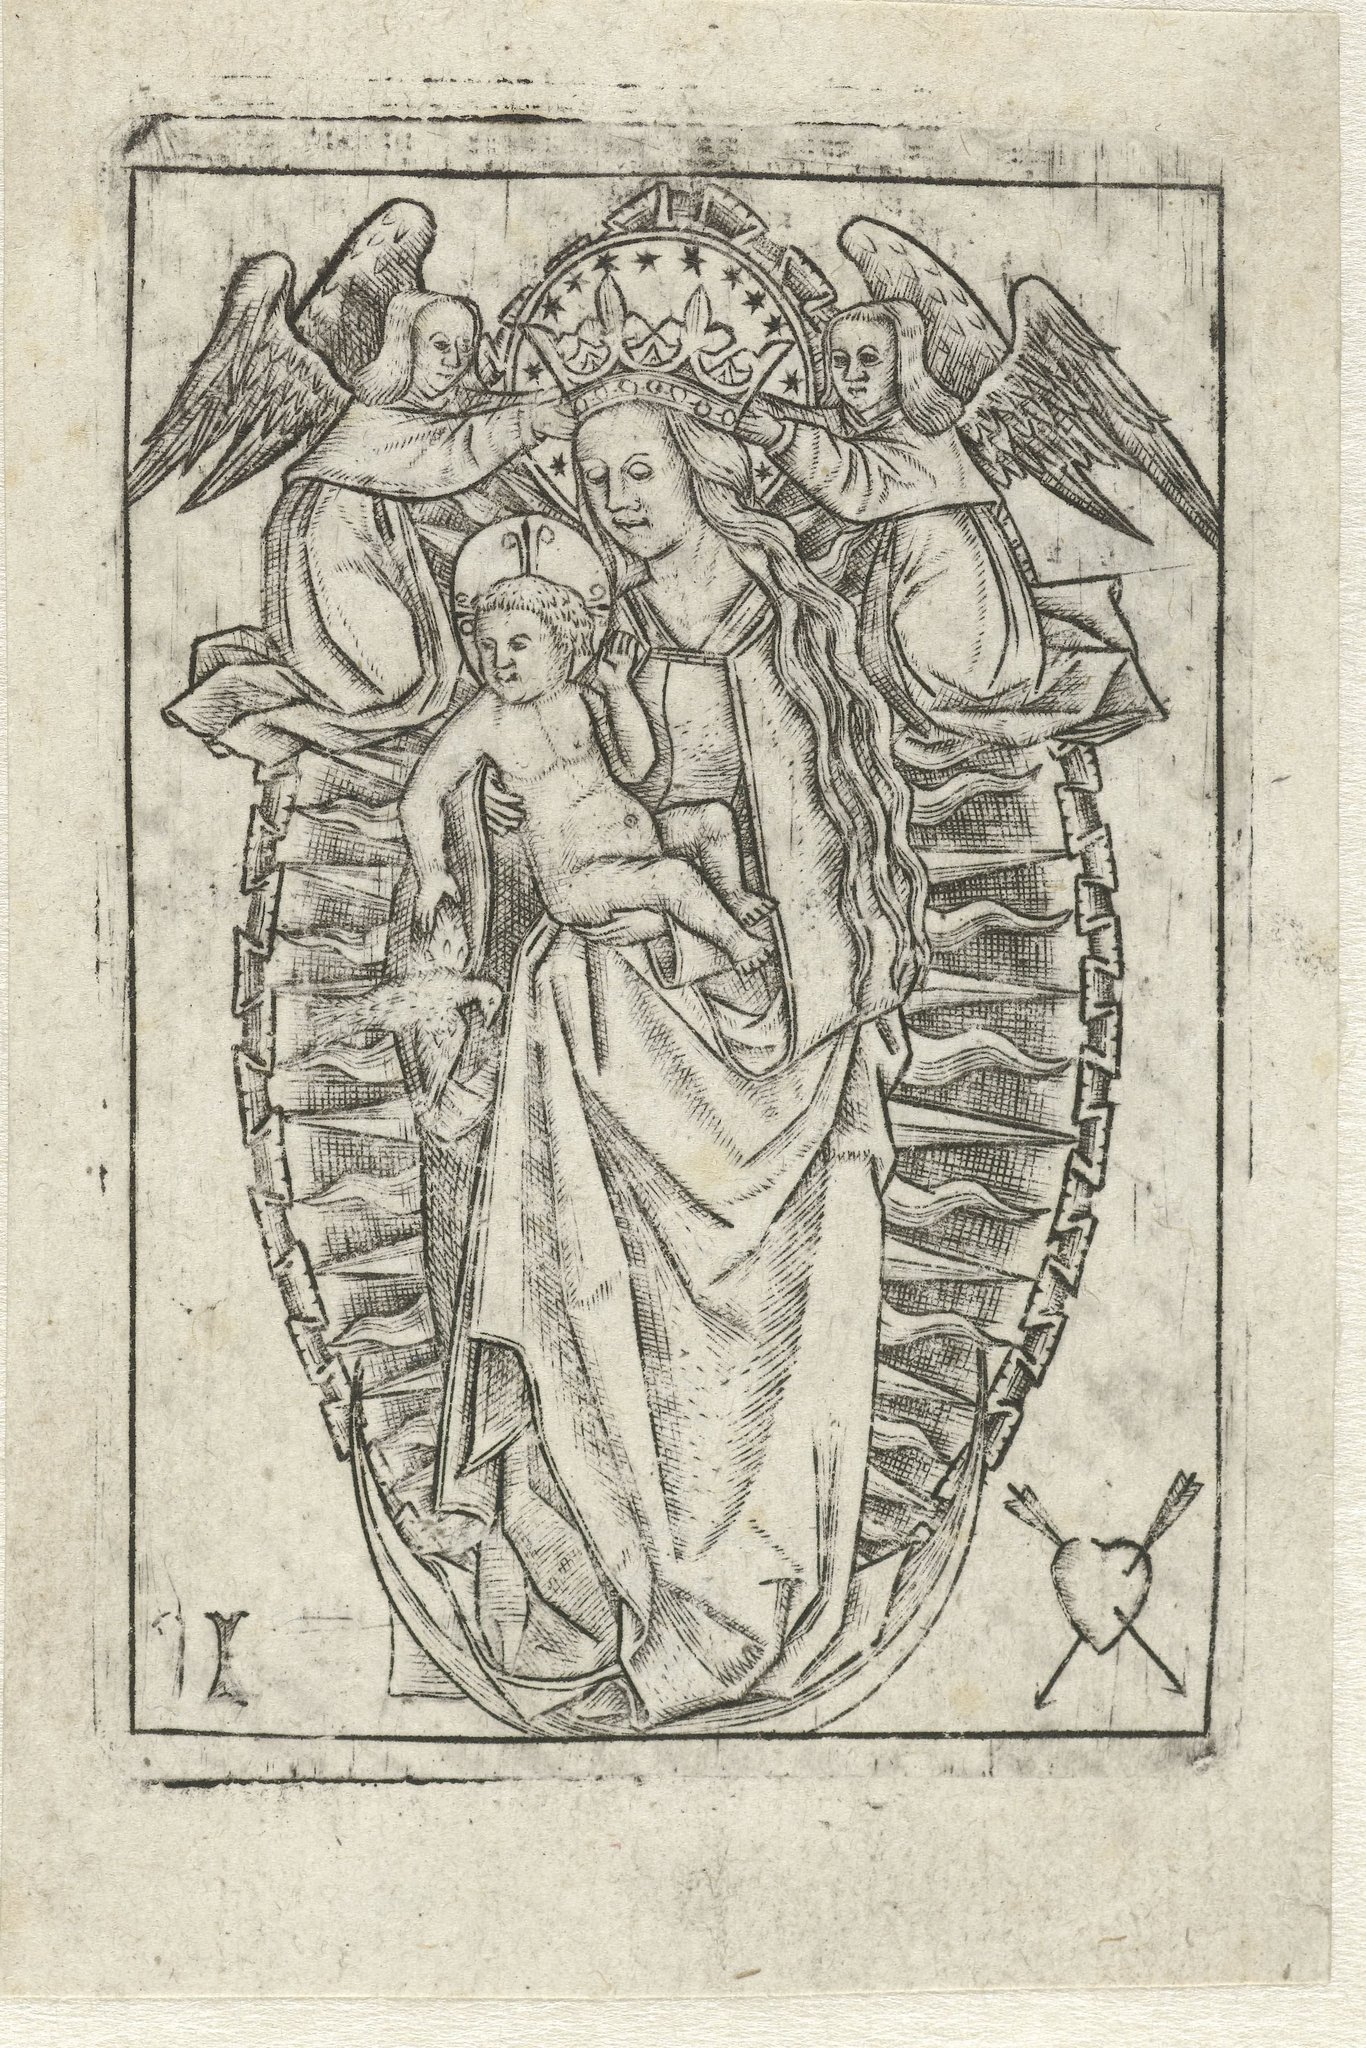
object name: print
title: Madonna op de maansikkel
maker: meester met het doorstoken hart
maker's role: print maker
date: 1500-1525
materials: paper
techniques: engraving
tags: madonna on the crescent of the moon (sometimes called queen of heaven) (in mandorla), christ-child holding something in his hand, e.g. apple, bird, cherries, crucifix, grapes, paper wind-mill ~ madonna-representations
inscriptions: collector's mark: Lugt 2228a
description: Madonna als hemelkoningin, met nimbus om het hoofd, omgeven door een stralenkrans en staand op de maansikkel. Ze wordt gekroond door twee engelen. Het Christuskind draagt ze op de rechterarm. Het kind houdt een duif vast bij een van de vleugels. Rechtsonder een door twee pijlen doorboord hart.